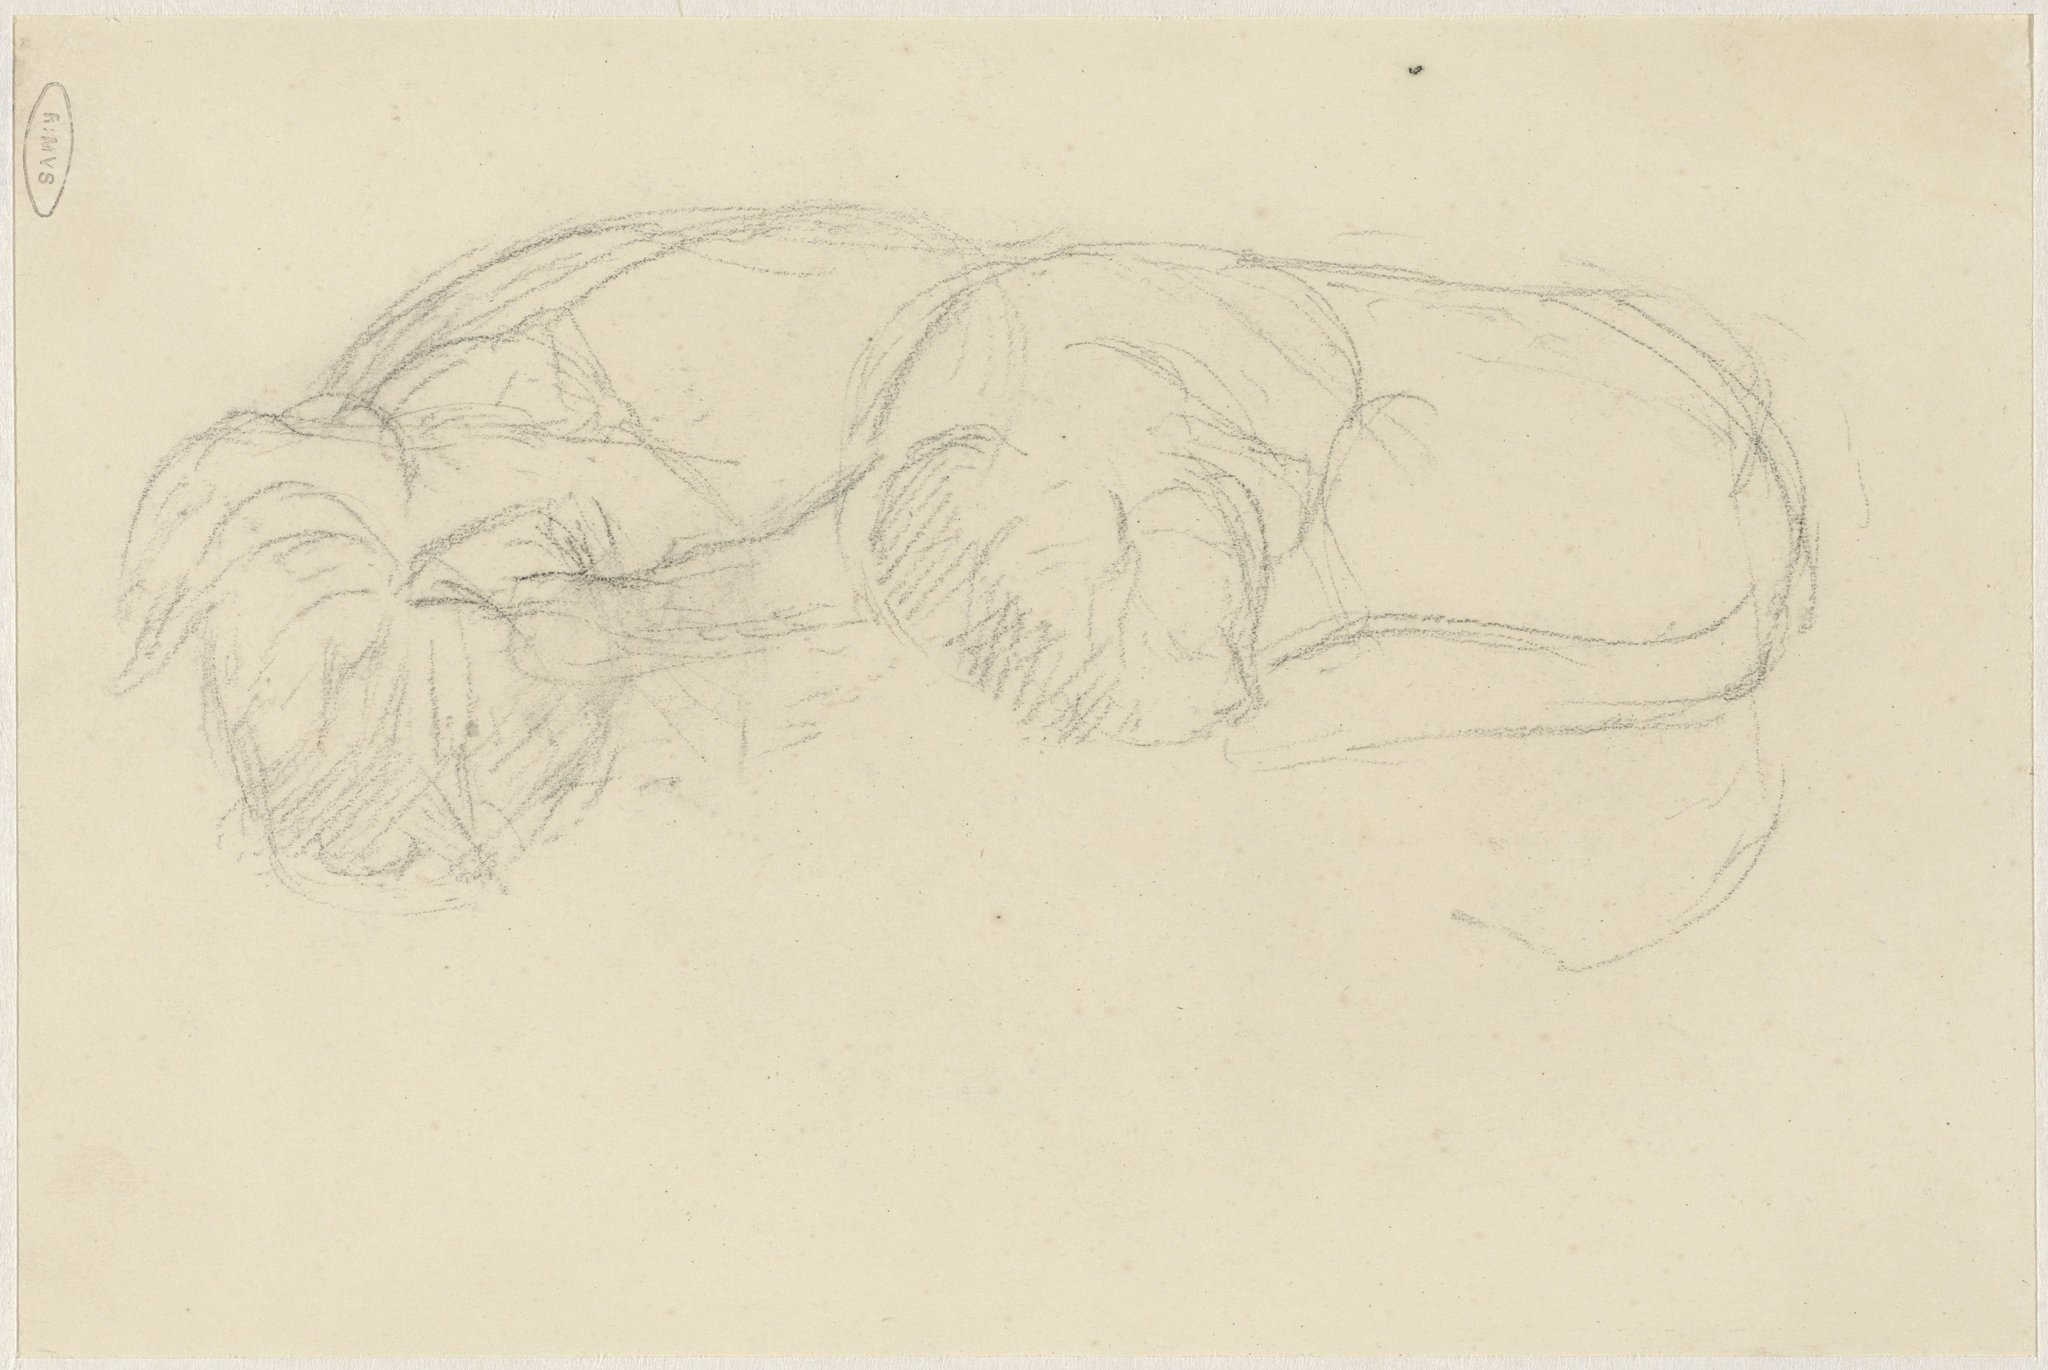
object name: drawing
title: Liggende hond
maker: jozef israëls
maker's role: draughtsman, painter, print maker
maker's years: 1824-1911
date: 1834-1911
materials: chalk, paper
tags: dog